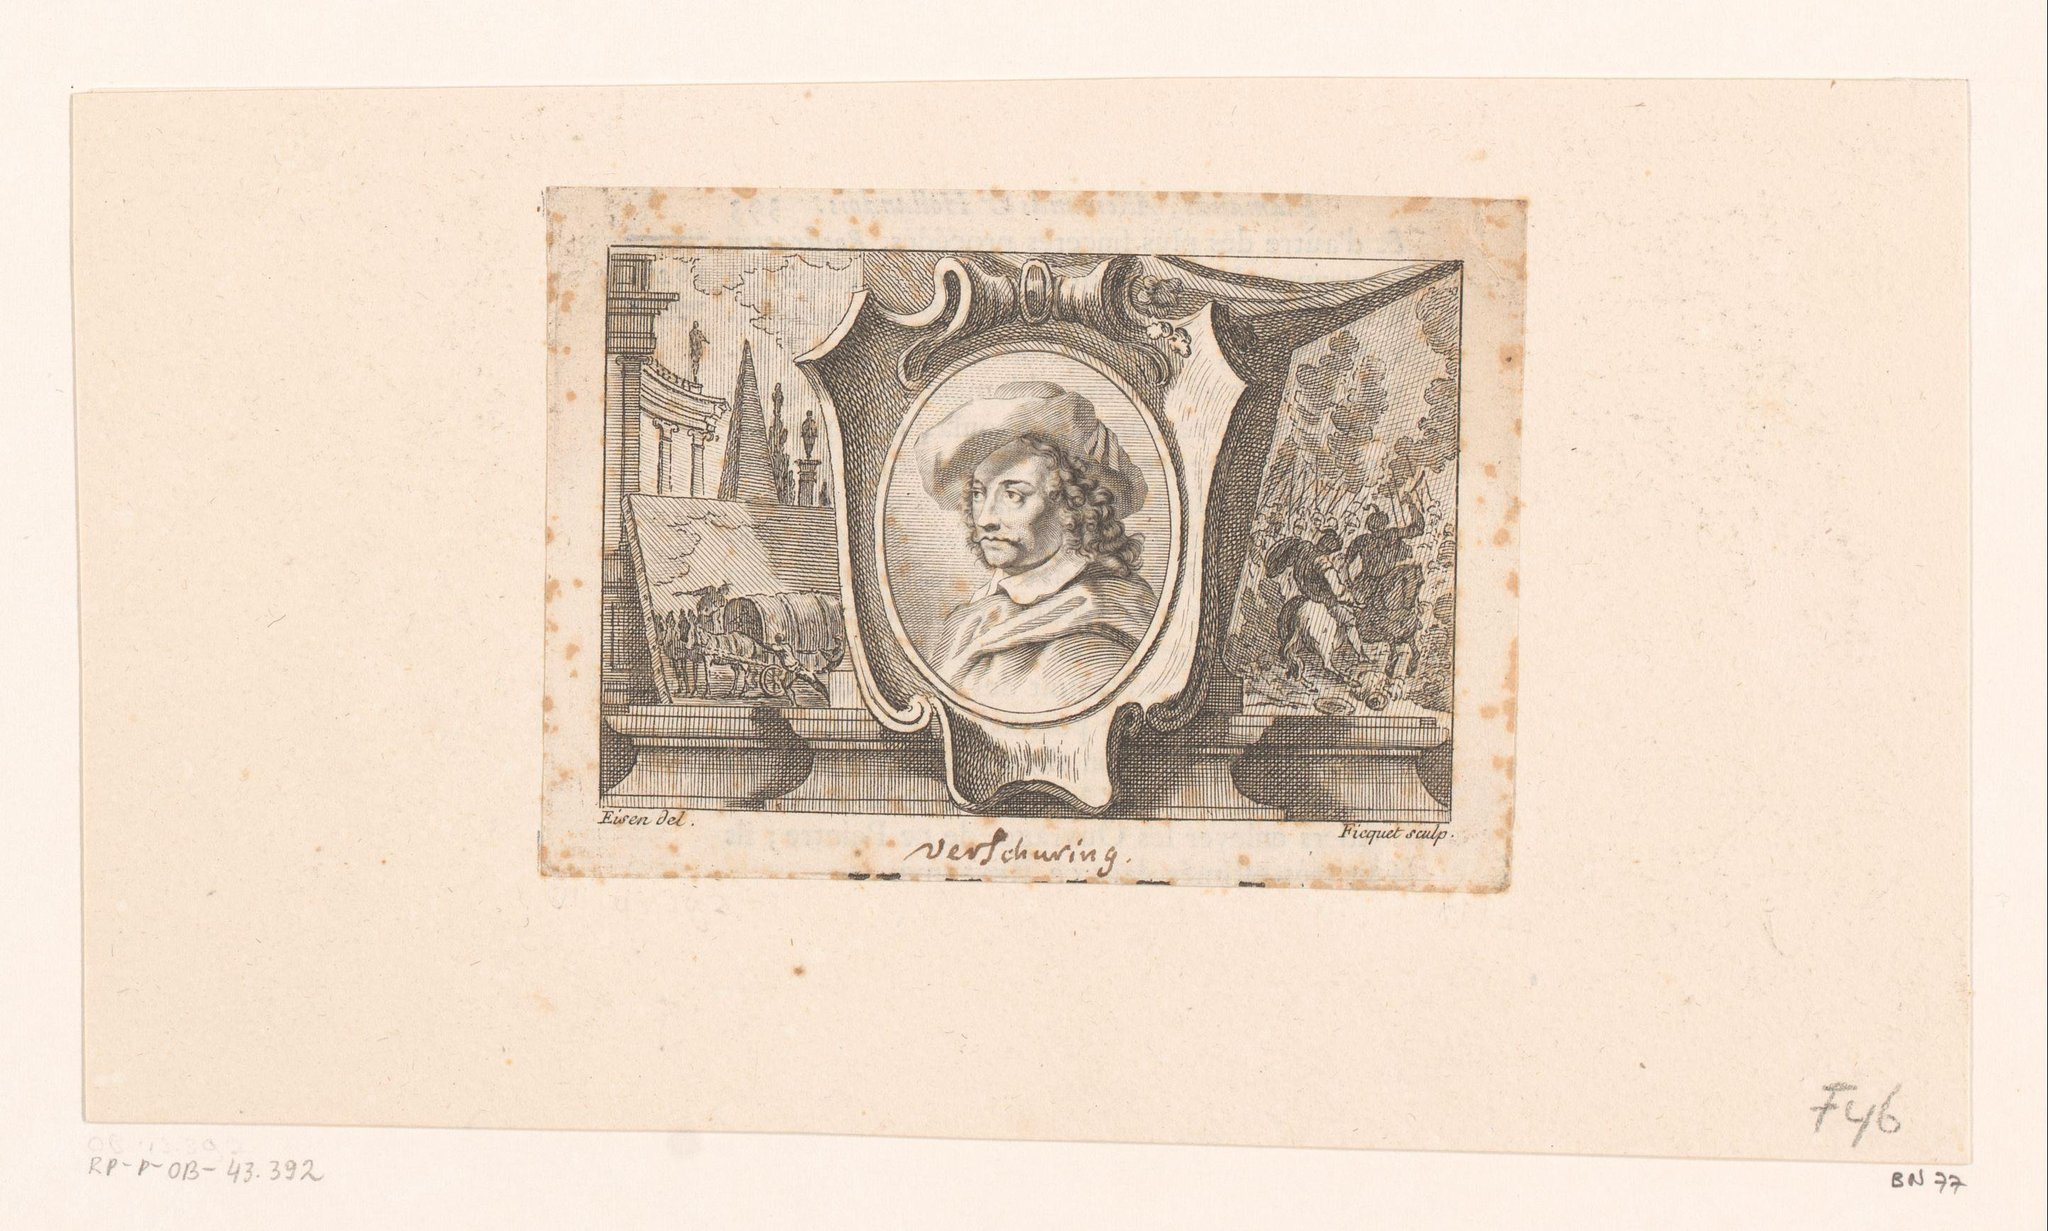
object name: print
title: Portret van Henrdrik Verschuring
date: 1753-1764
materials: paper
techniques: engraving, etching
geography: france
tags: dordrecht, print maker, draughtsman, hendrik verschuring, ornament ~ medallion, historical persons, portrait, self-portrait of painter, portrait, self-portrait of graphic artist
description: Prent uit: Descamps. La vie des peintres flamands allemands et hollandois. Parijs: Jombert, 1753-1764, dl. 2.